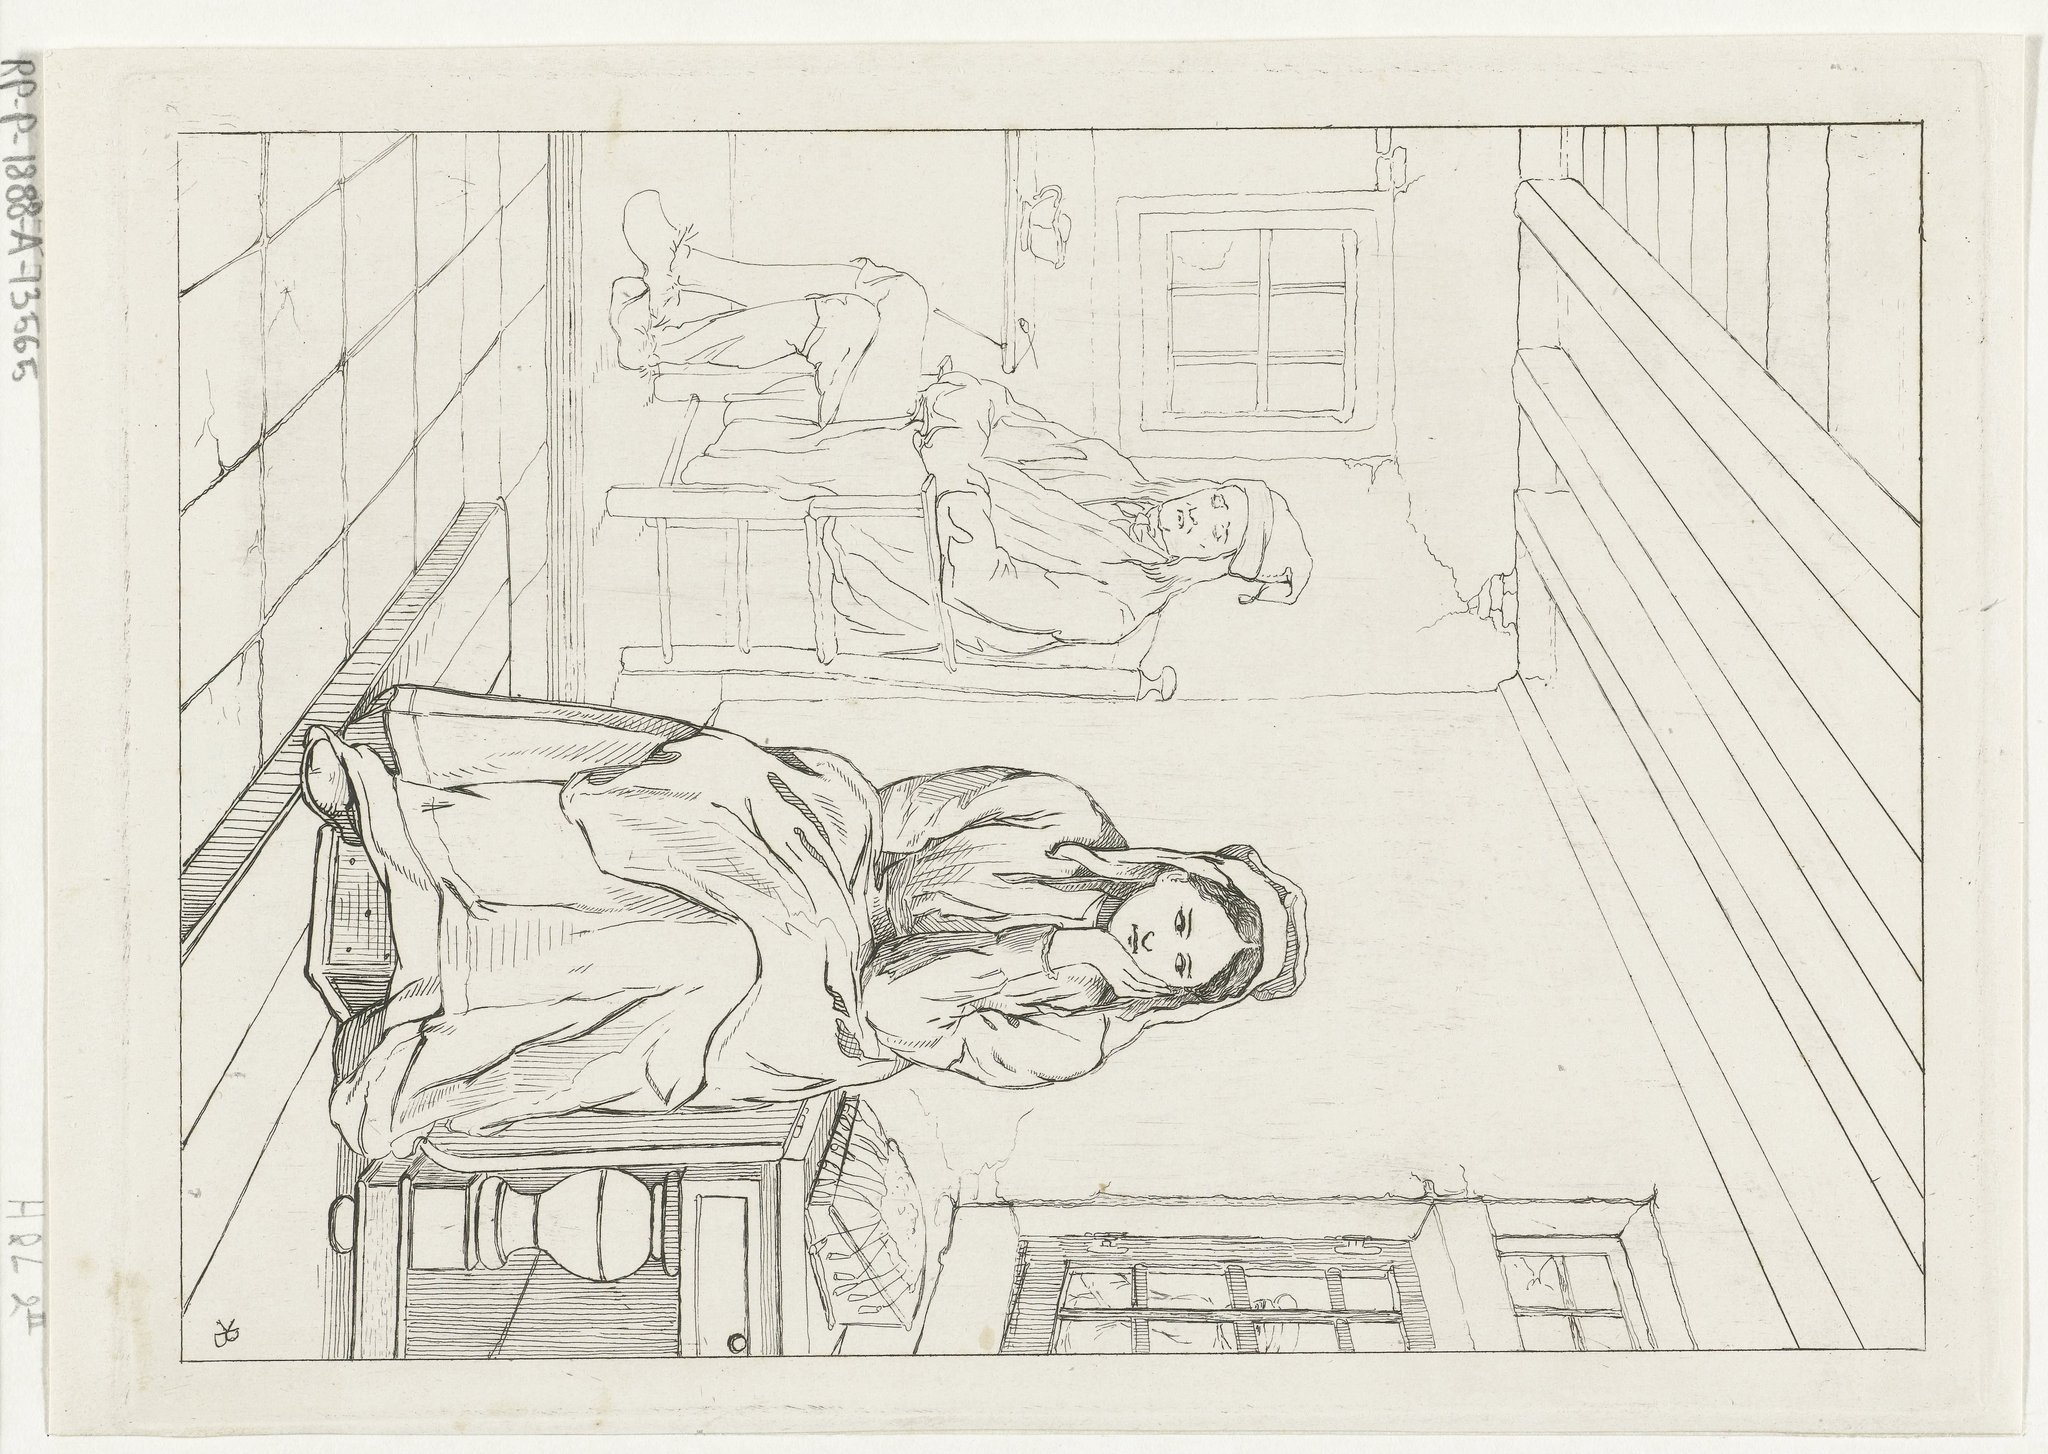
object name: print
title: Verzorgster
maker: karel frederik bombled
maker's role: draughtsman, print maker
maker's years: 1822-1902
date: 1832-1888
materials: paper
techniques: etching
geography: netherlands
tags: sleeping in chair, (other forms of) needlework, e.g.: crocheting, knitting, embroidering, nursing, tending the sick, lover (woman) alone (e.g. longing for the beloved), the (nude) human figure; 'corpo humano' (ripa) (+ old male (human being))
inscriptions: collector's mark: Lugt 2228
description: Achterin de kamer zit een oude man in een stoel te slapen. Rechts op de voorgrond kijkt zijn verzorgster verveeld het raam uit. Haar borduurwerk ligt onberoerd naast haar op tafel. Door het raam kan men de contouren van een jongeling herkennen.